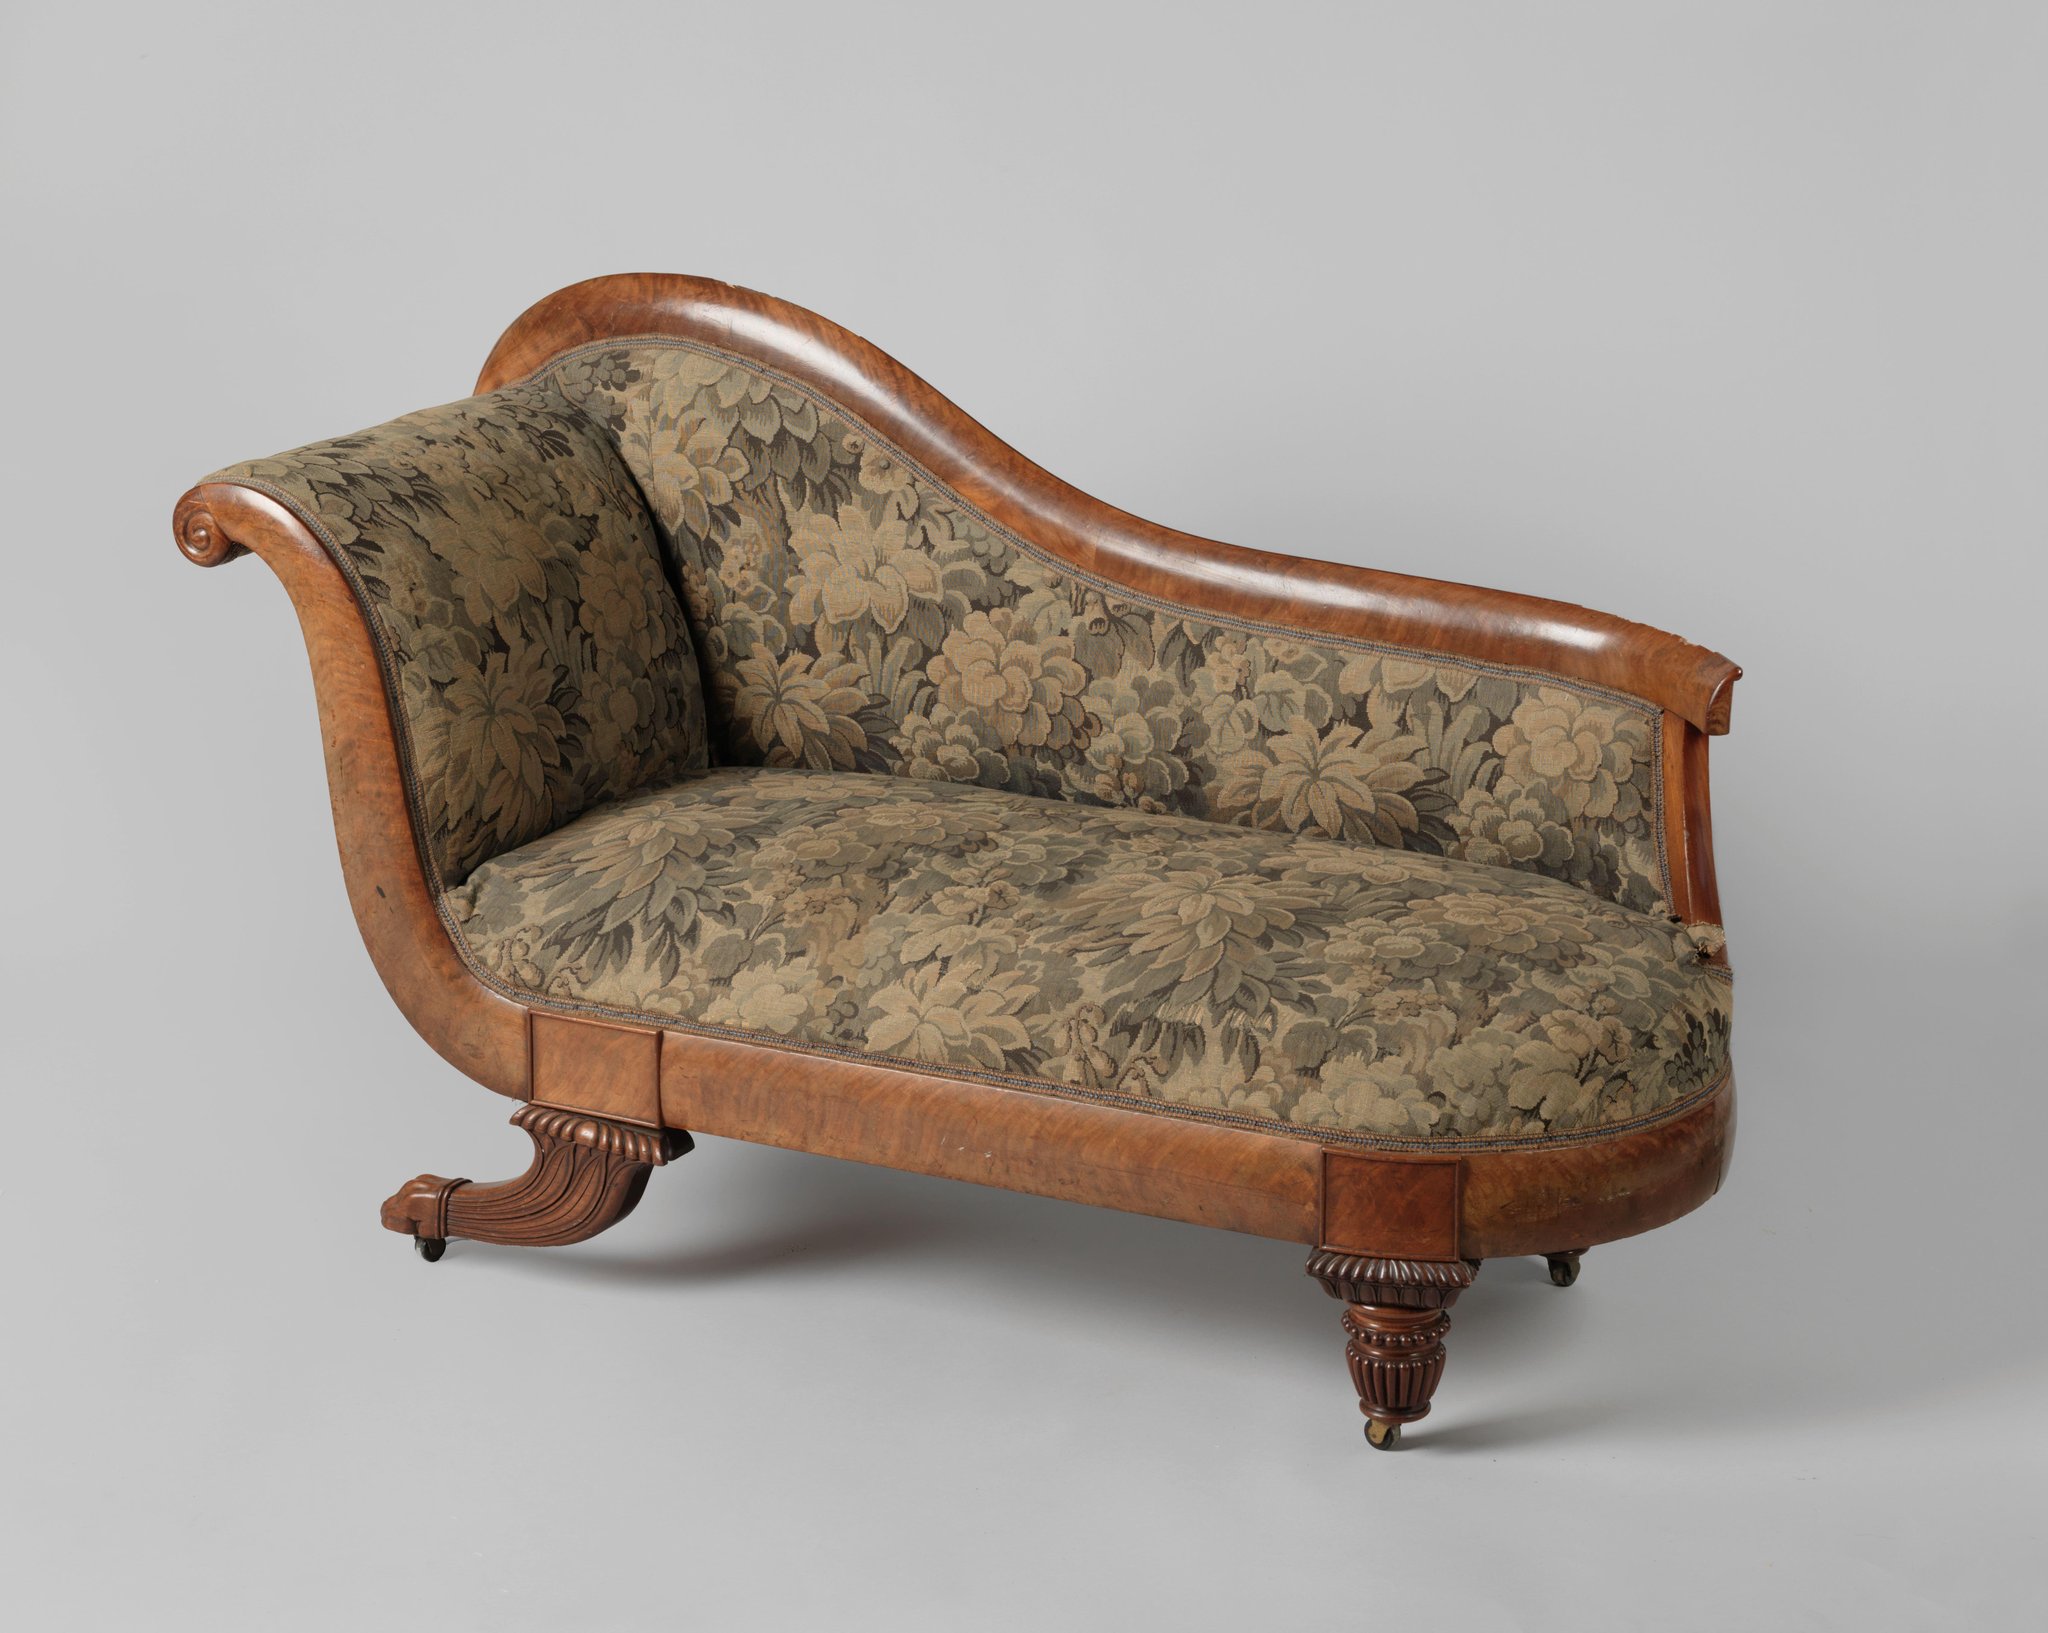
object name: seating furniture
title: Bank bekleed met gobelin en rustend op twee conische en op twee hoornvormige poten op een klauw, waaronder wielen.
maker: Anonymous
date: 1840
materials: wood, textile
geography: northern netherlands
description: Mahoniehouten bank bekleed met gobelin en rustend op twee conische zijpoten en op twee zijpoten in de vorm van een hoorn, op een klauw. Onder de poten zijn wielen aangebracht. Het rechthoekige zitraam is aan één zijde afgerond. De voorregel, die boven de poten een langwerpig verdikt veld vertoont, loopt over in de zijleuning, eindigend in een voluut. De rug heeft een grote voluutvorm, aan de ene kant rustend op de zijleuning; aan de andere op een binnenwaarts gewende stut. Zie: BK-1959-113-b.